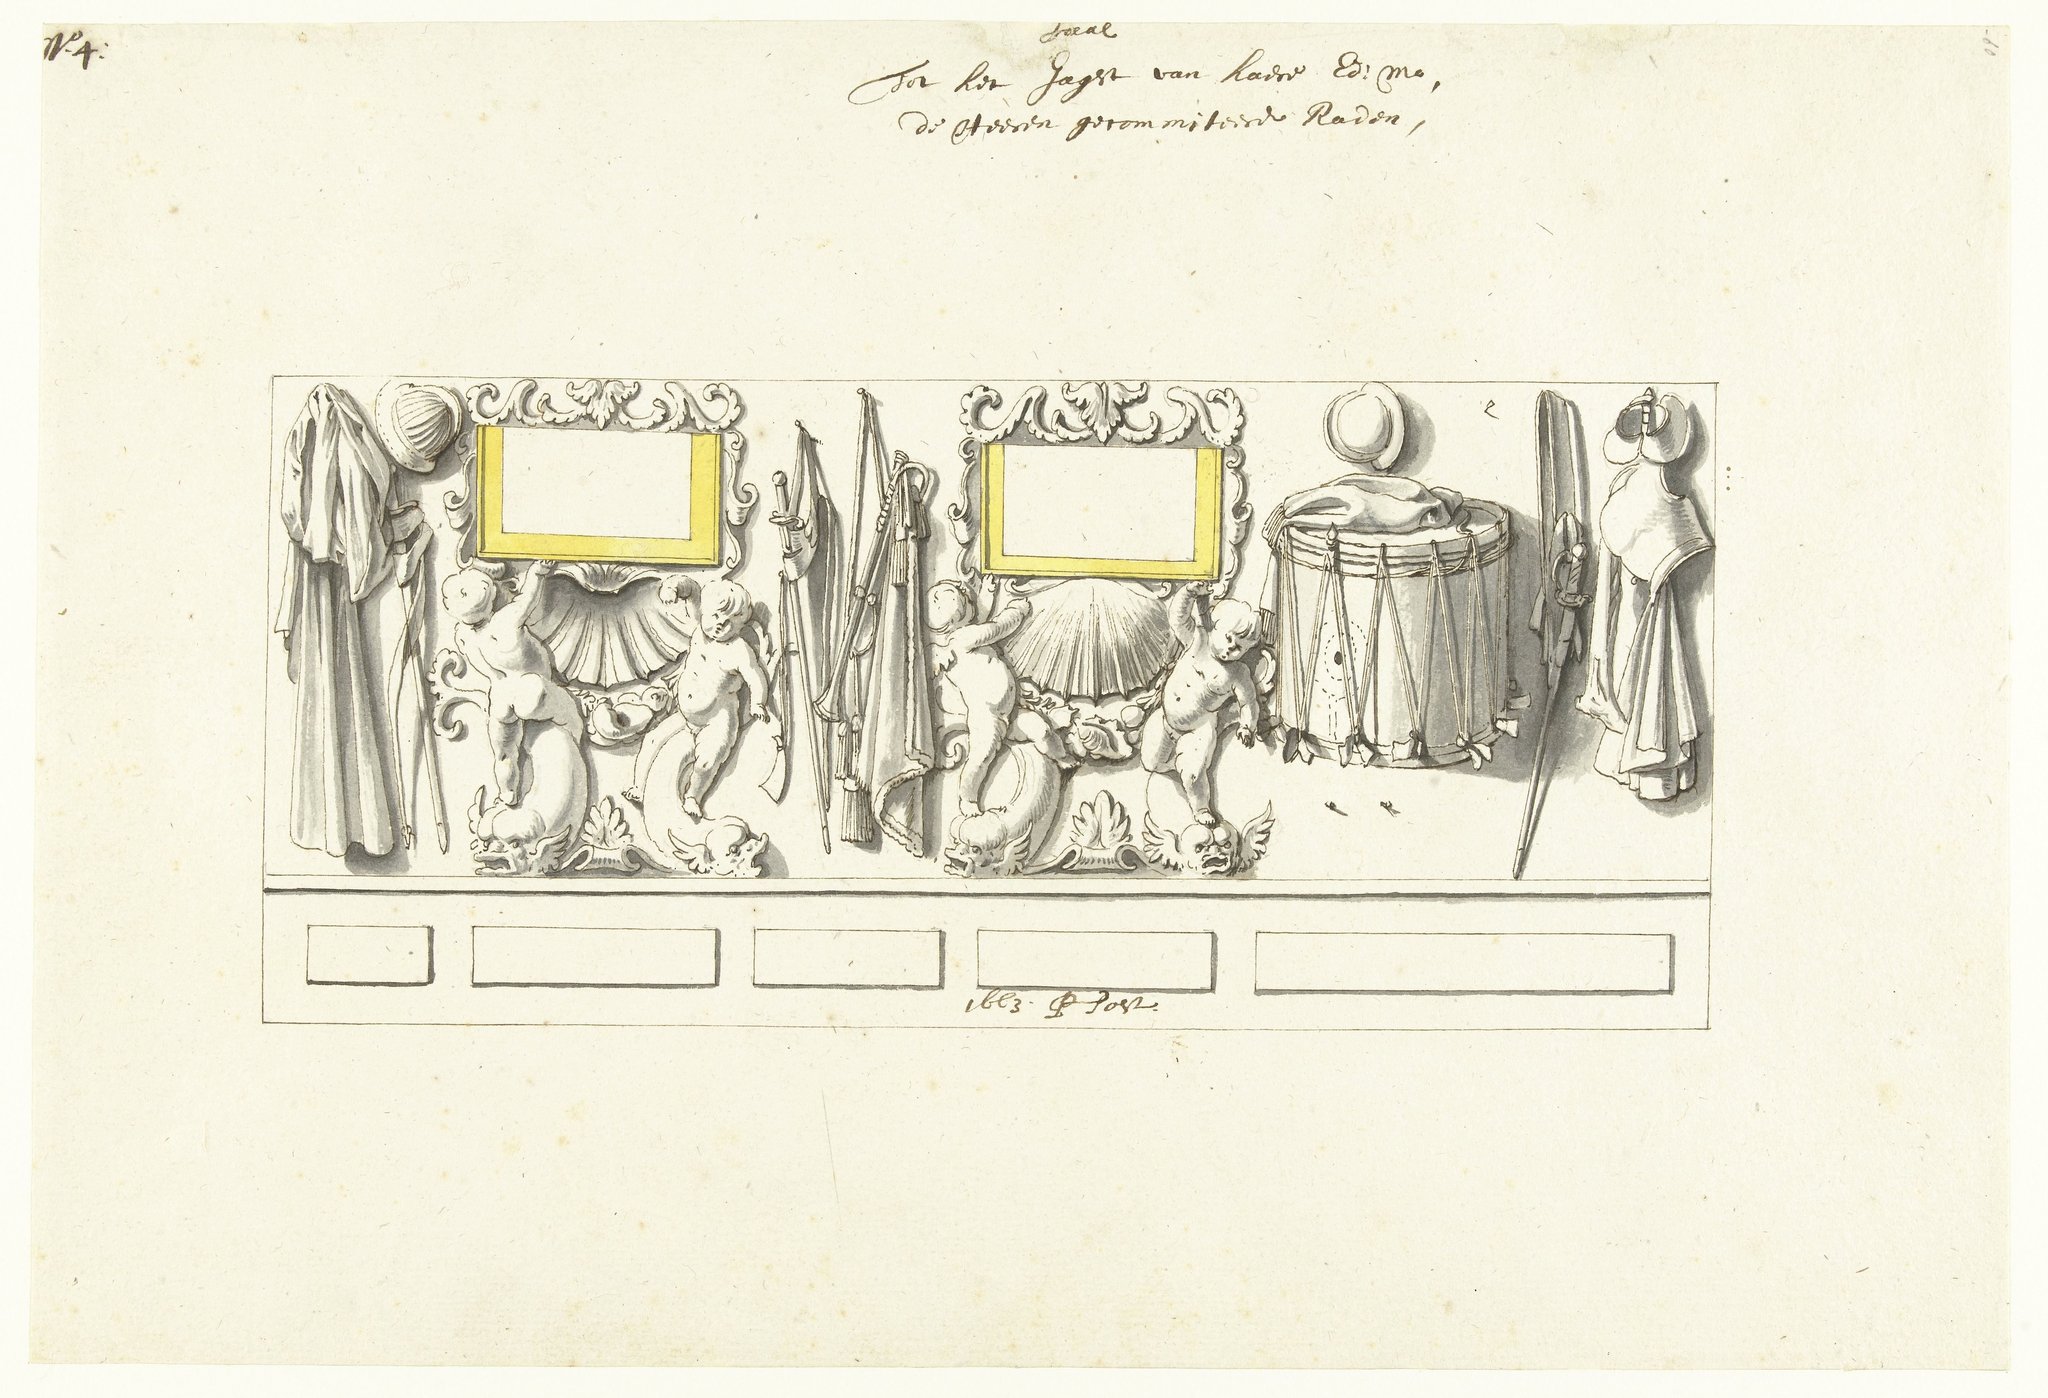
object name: drawing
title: Interieurdecoraties van het statenjacht der Gecommitteerde Raden van Holland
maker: pieter jansz. post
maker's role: draughtsman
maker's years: 1608-1669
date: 1663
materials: ink, paper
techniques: brush, pen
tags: 'tropaion', i.e. decorative ornament ~ weapons, parts of ship's interior, wall-covering, cupids: 'amores', 'amoretti', 'putti'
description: Ontwerpen voor decoraties van het interieur van het statenjacht van de Gecommitteerde Raden van Holland: zaal, zijwand met trofeeën.